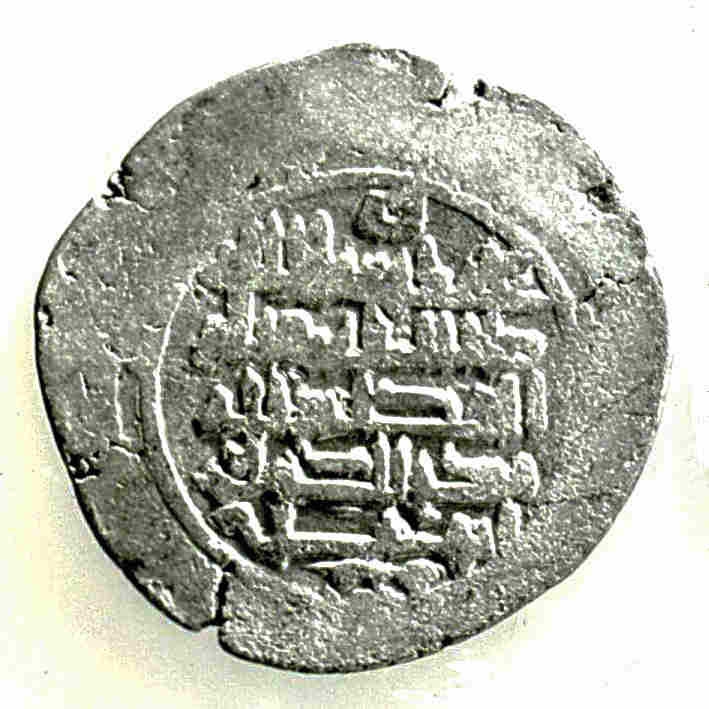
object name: coin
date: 901-1000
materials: silver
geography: iran